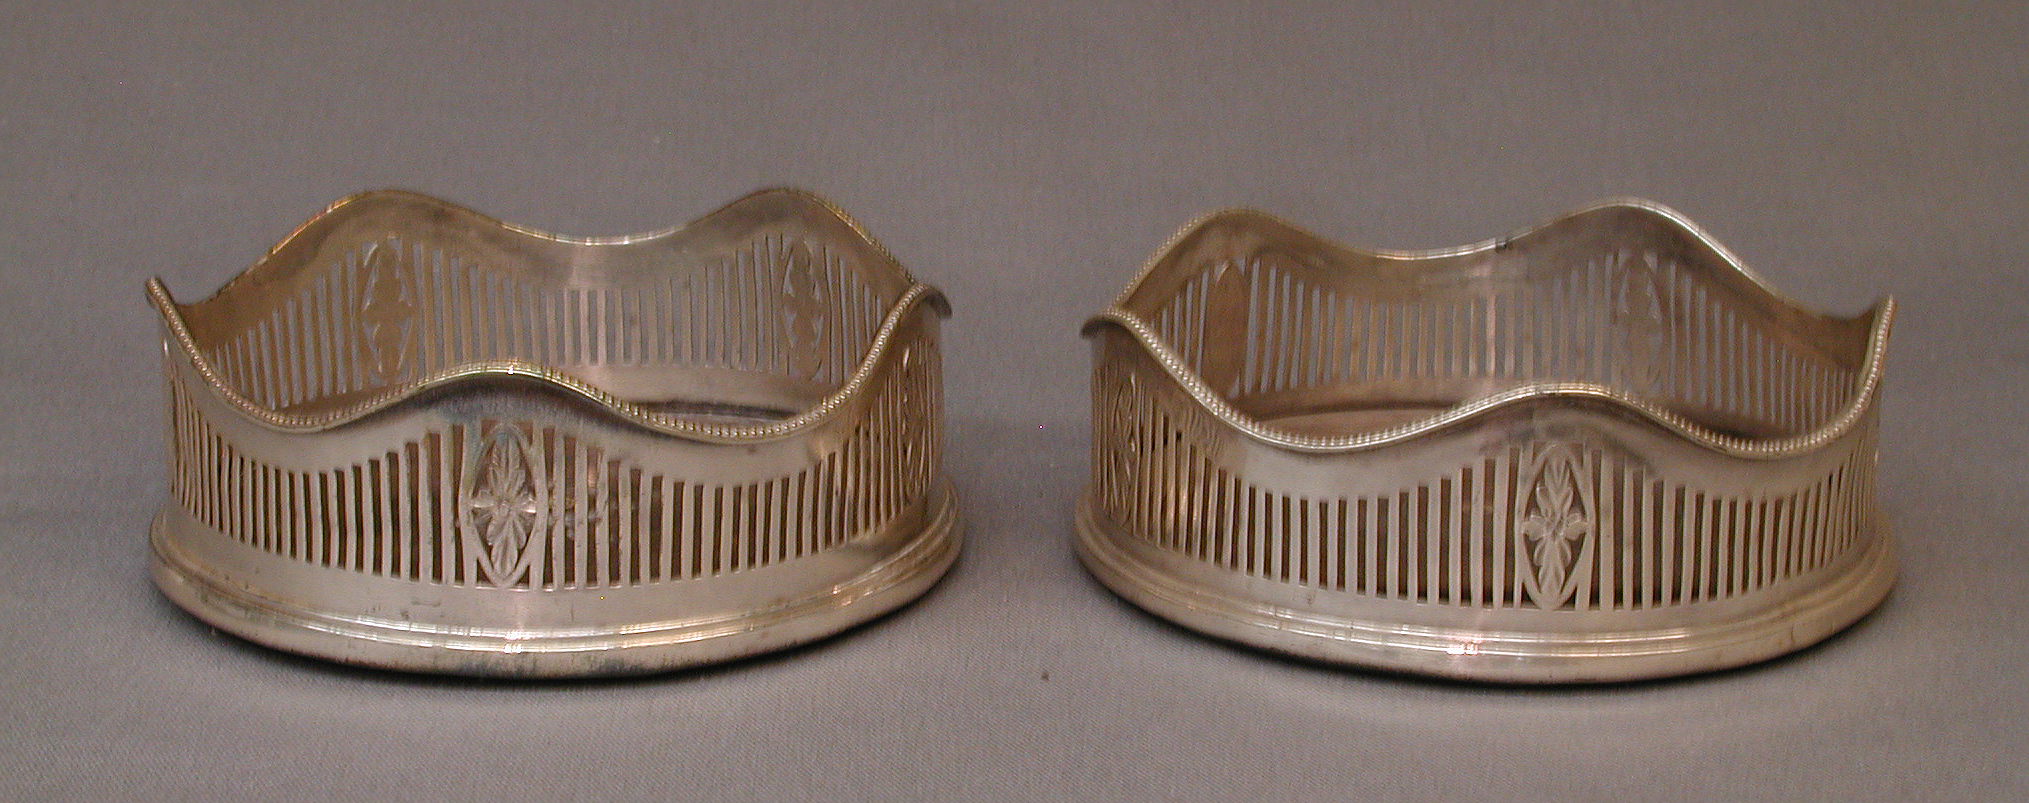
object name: coaster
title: Two coasters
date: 1785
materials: metal